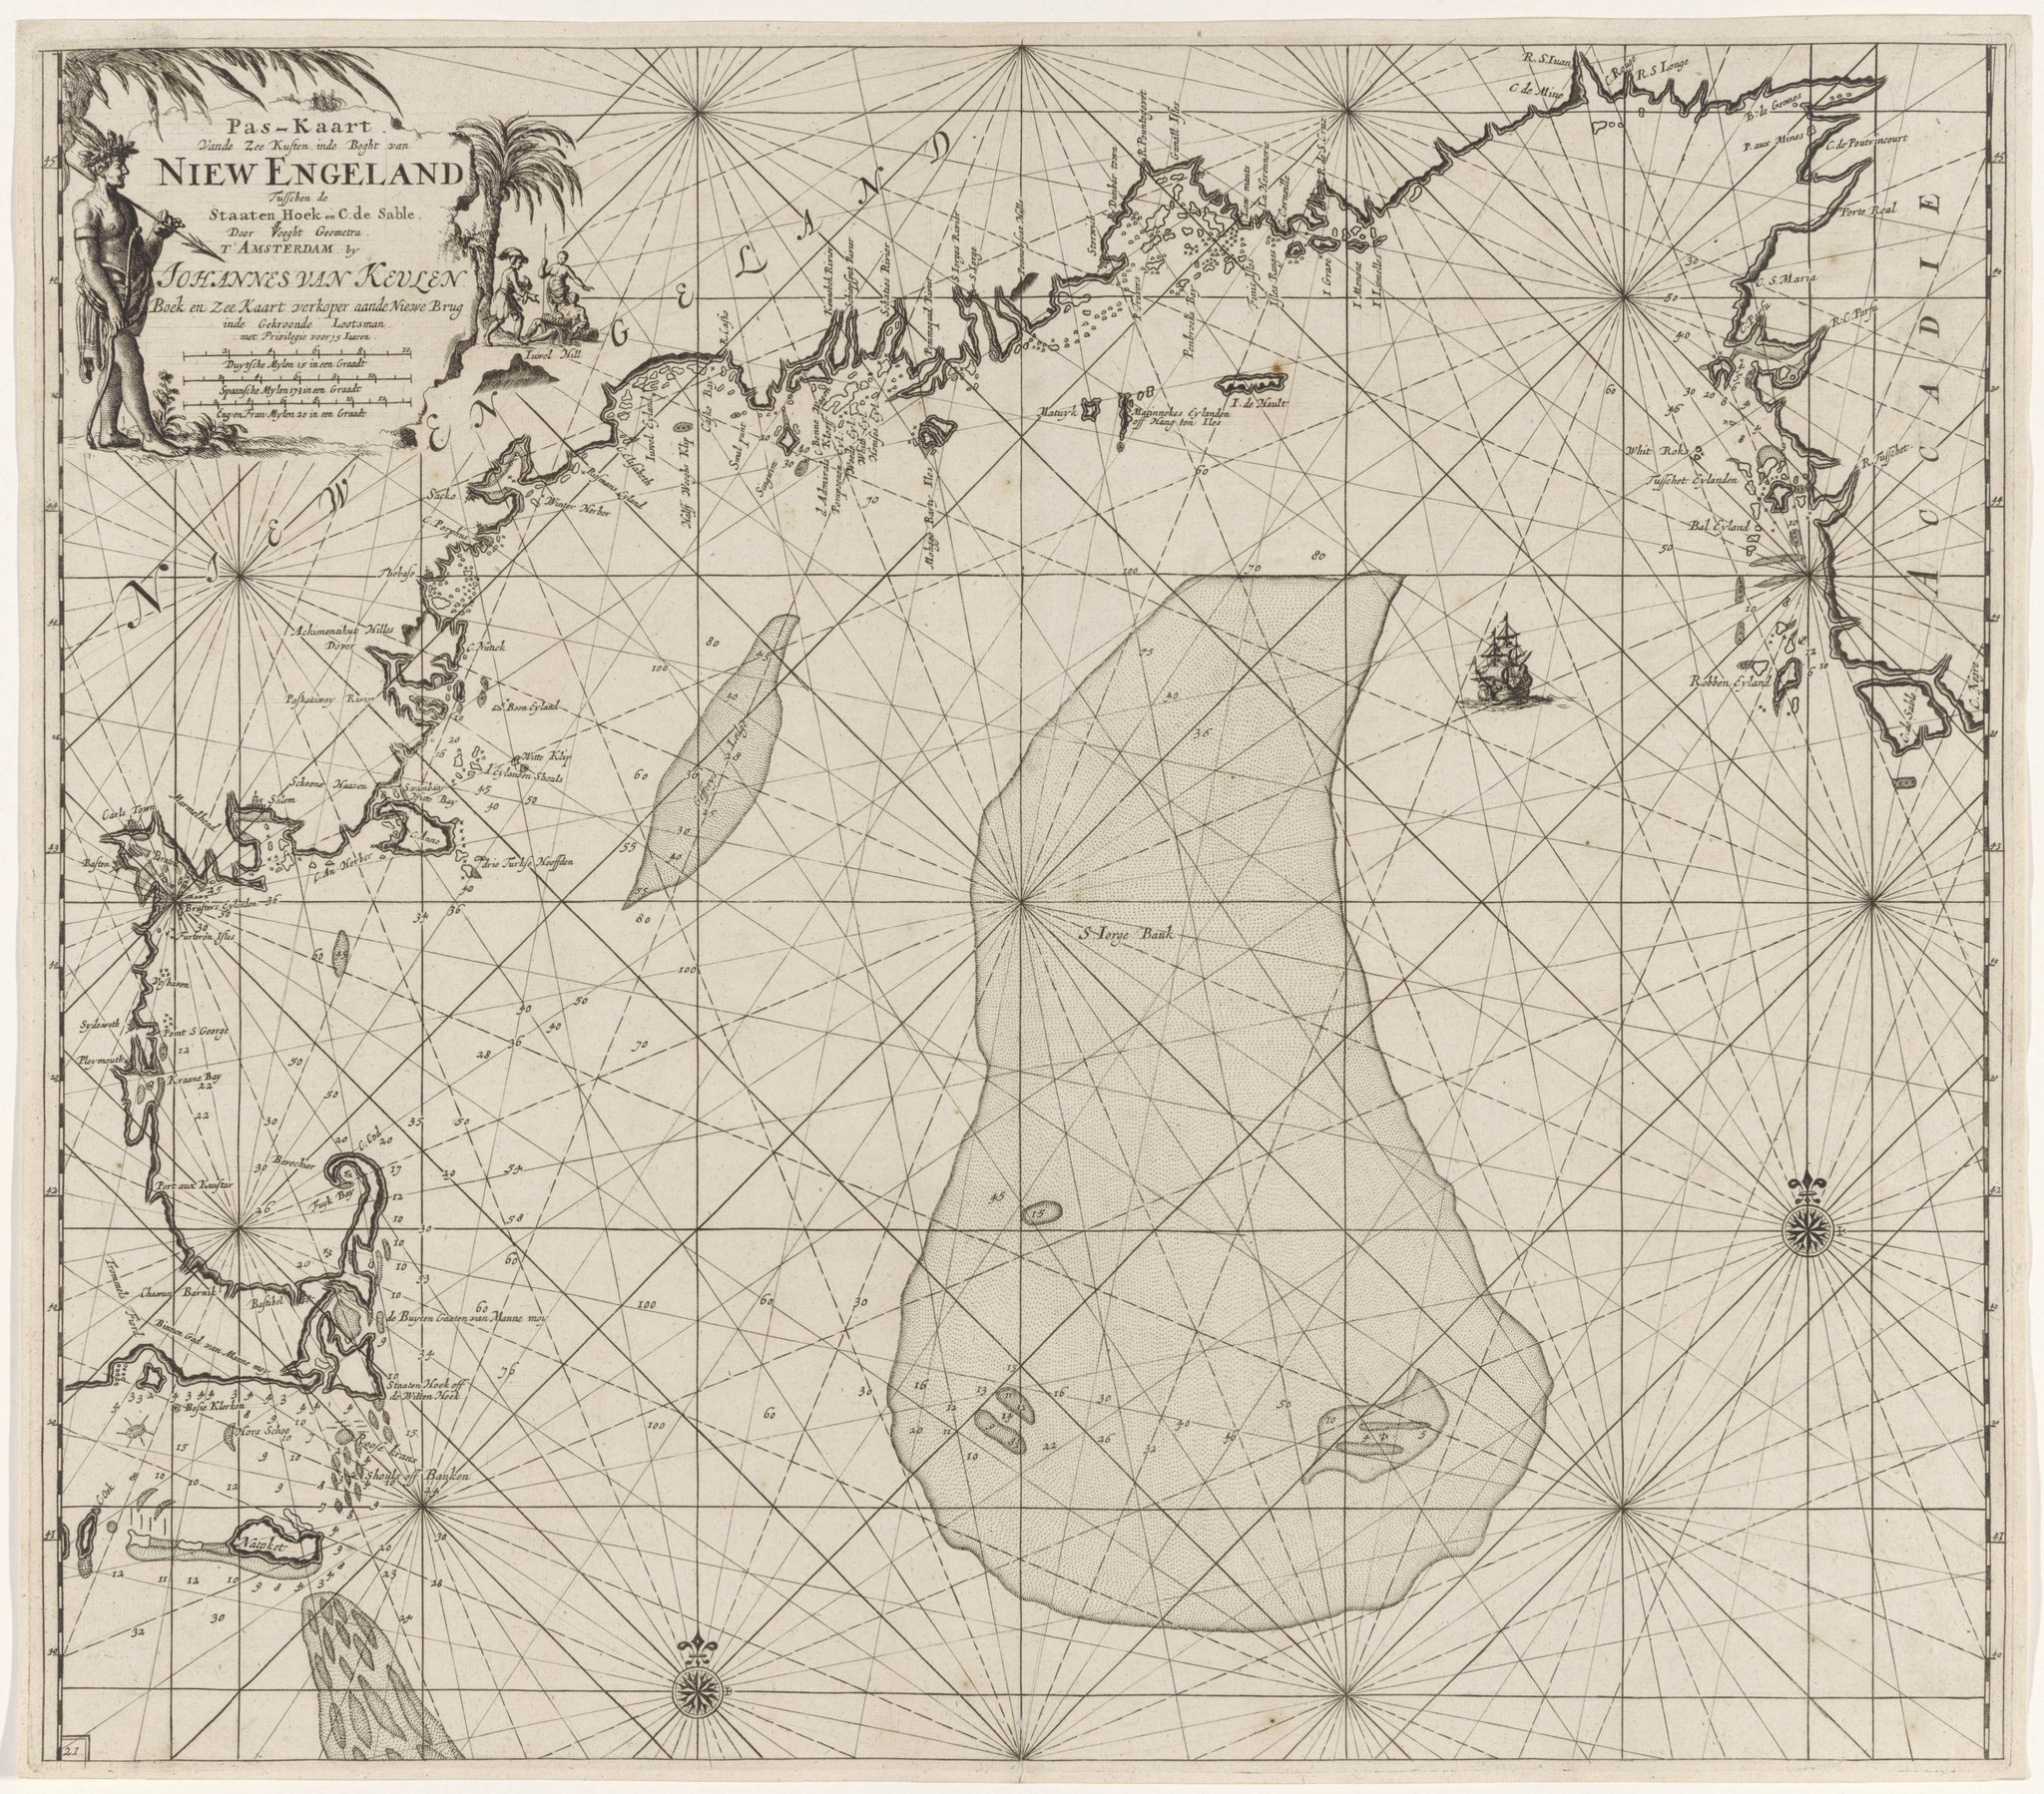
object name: print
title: Pas-kaart vande zee kusten inde boght van Niew Engeland tusschen de Staaten Hoek en C. de Sable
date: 1684-1799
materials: paper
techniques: engraving, etching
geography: amsterdam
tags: sailing-ship, sailing-boat, archer's weapons: bow and arrow, indigenous peoples of north america, trees: palm-tree, canada, united states of america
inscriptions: collector's mark: Lugt 2228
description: Paskaart van een deel van de oostkust van de Verenigde Staten en Canada, tussen Nantucket en Kaap Sable, met twee kompasrozen, het Noorden ligt links. Linksboven de titel, het uitgeversadres en de schaalverdeling, weergegeven in Duitse, Spaanse en Engelse of Franse mijlen (schaal: c. 1:1.100.000). De gegevens zijn geflankeerd door twee bomen, een krijger met wapenuitrusting en op de achtergrond drie mannen die handel drijven.